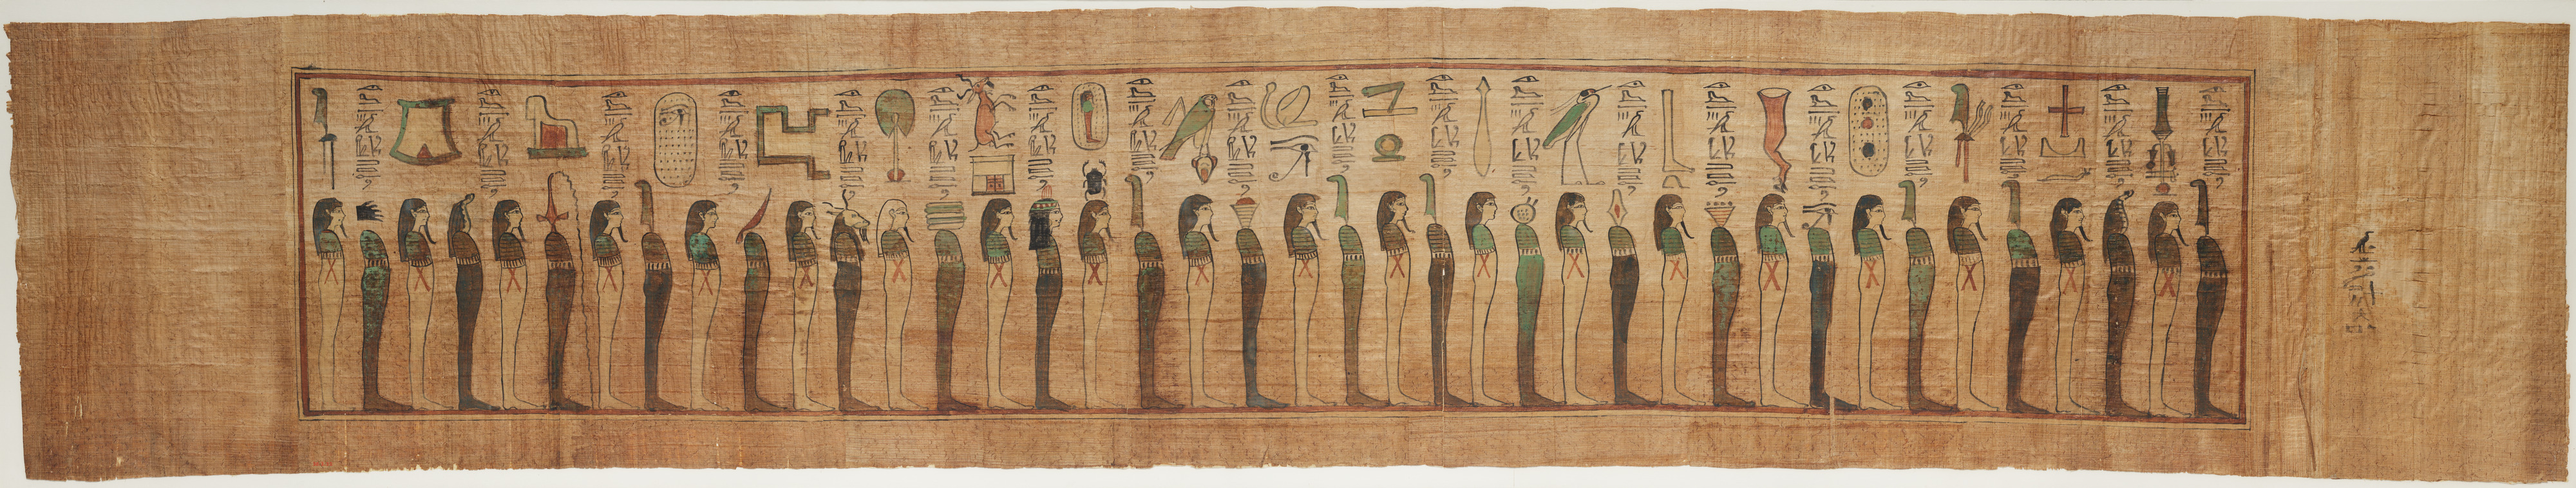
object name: papyrus, funerary, amduat, nauny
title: Funerary Papyrus of Nauny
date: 1050 BCE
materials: paint, papyrus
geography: egypt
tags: human figures,hieroglyphs